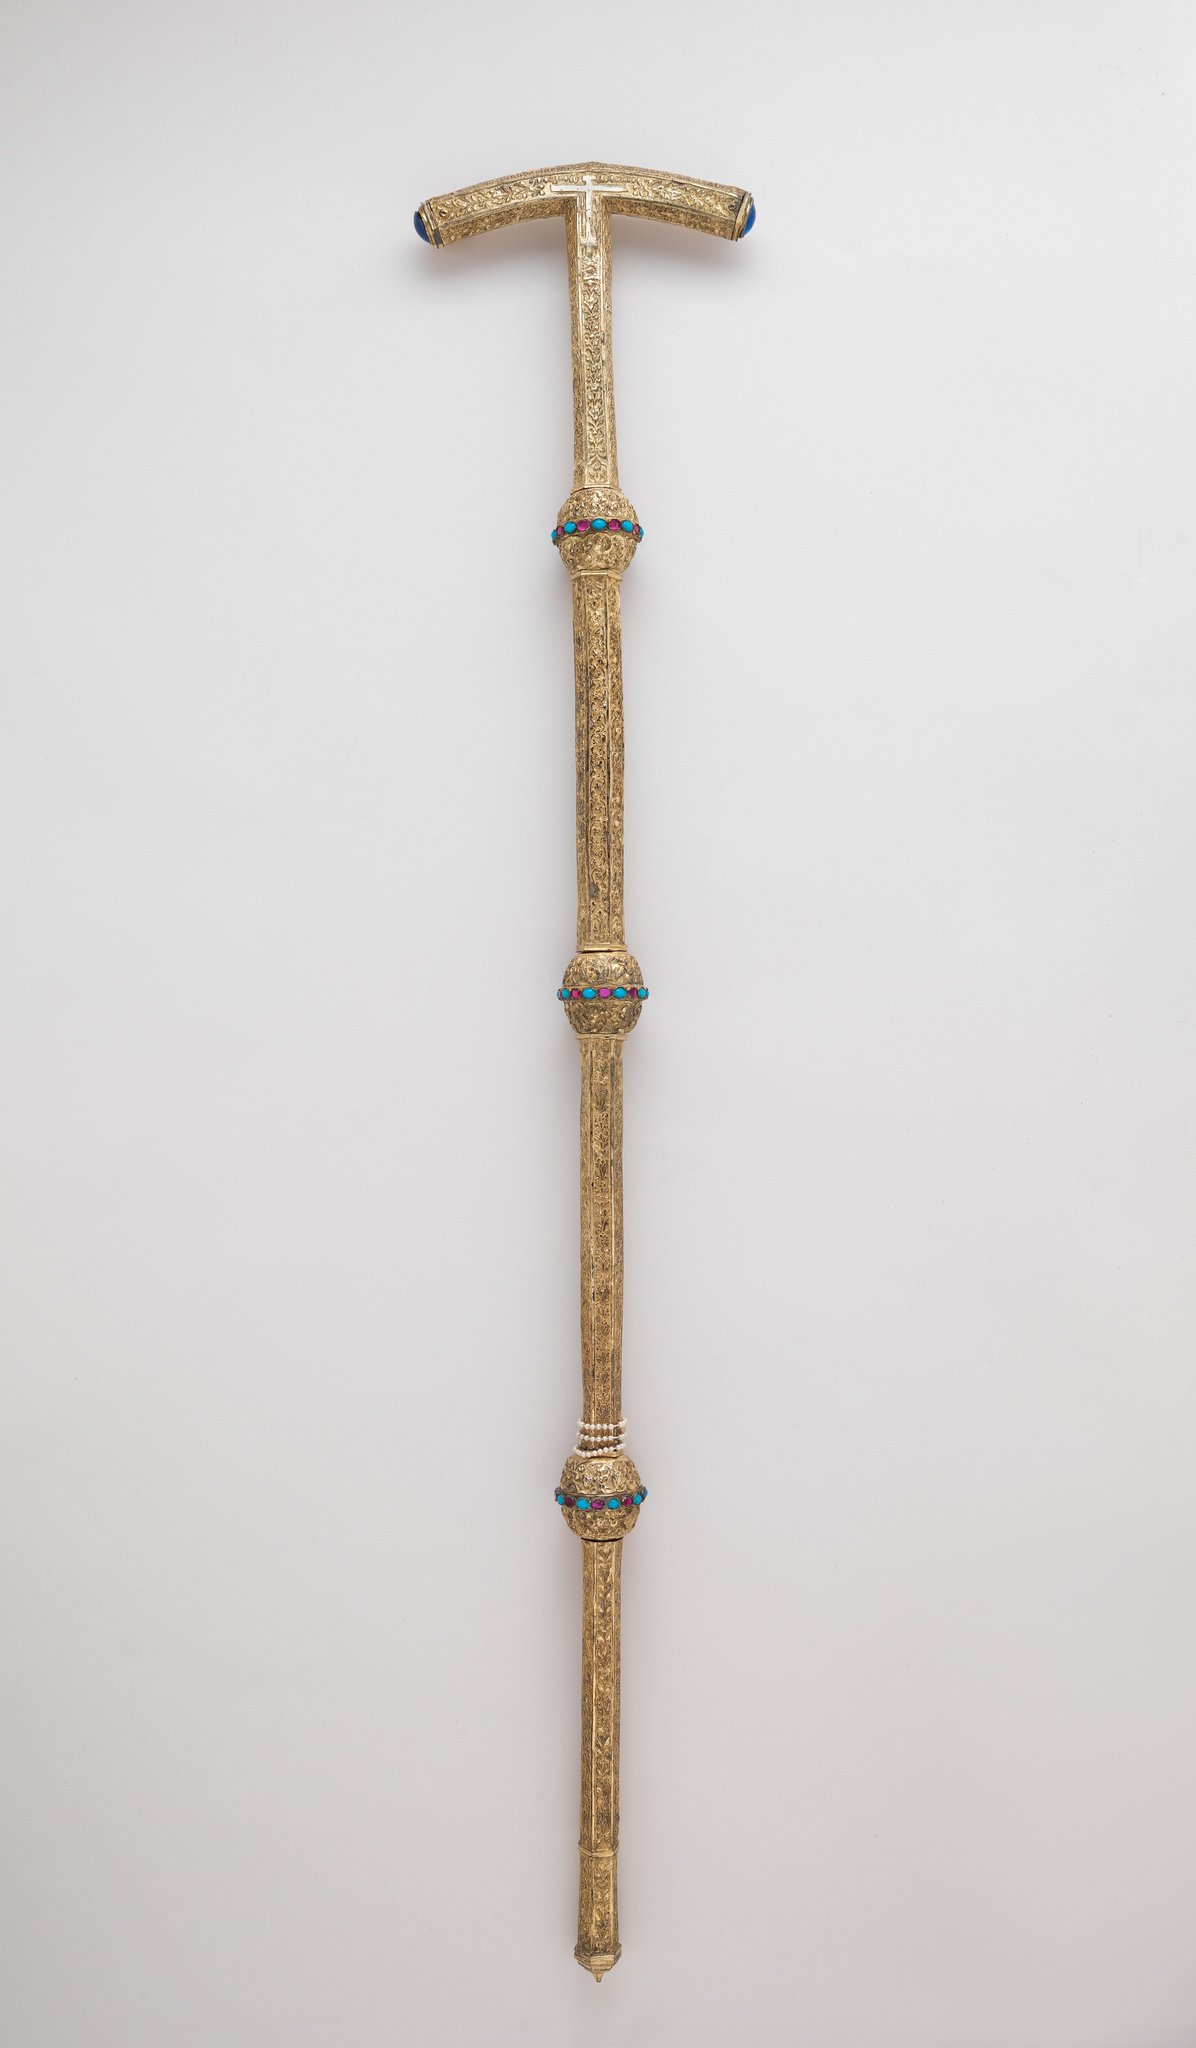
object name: pastoral staff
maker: elkington & co.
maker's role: manufacturer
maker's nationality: british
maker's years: 1829-1963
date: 1801-1900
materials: silver gilt, wood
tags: croziers